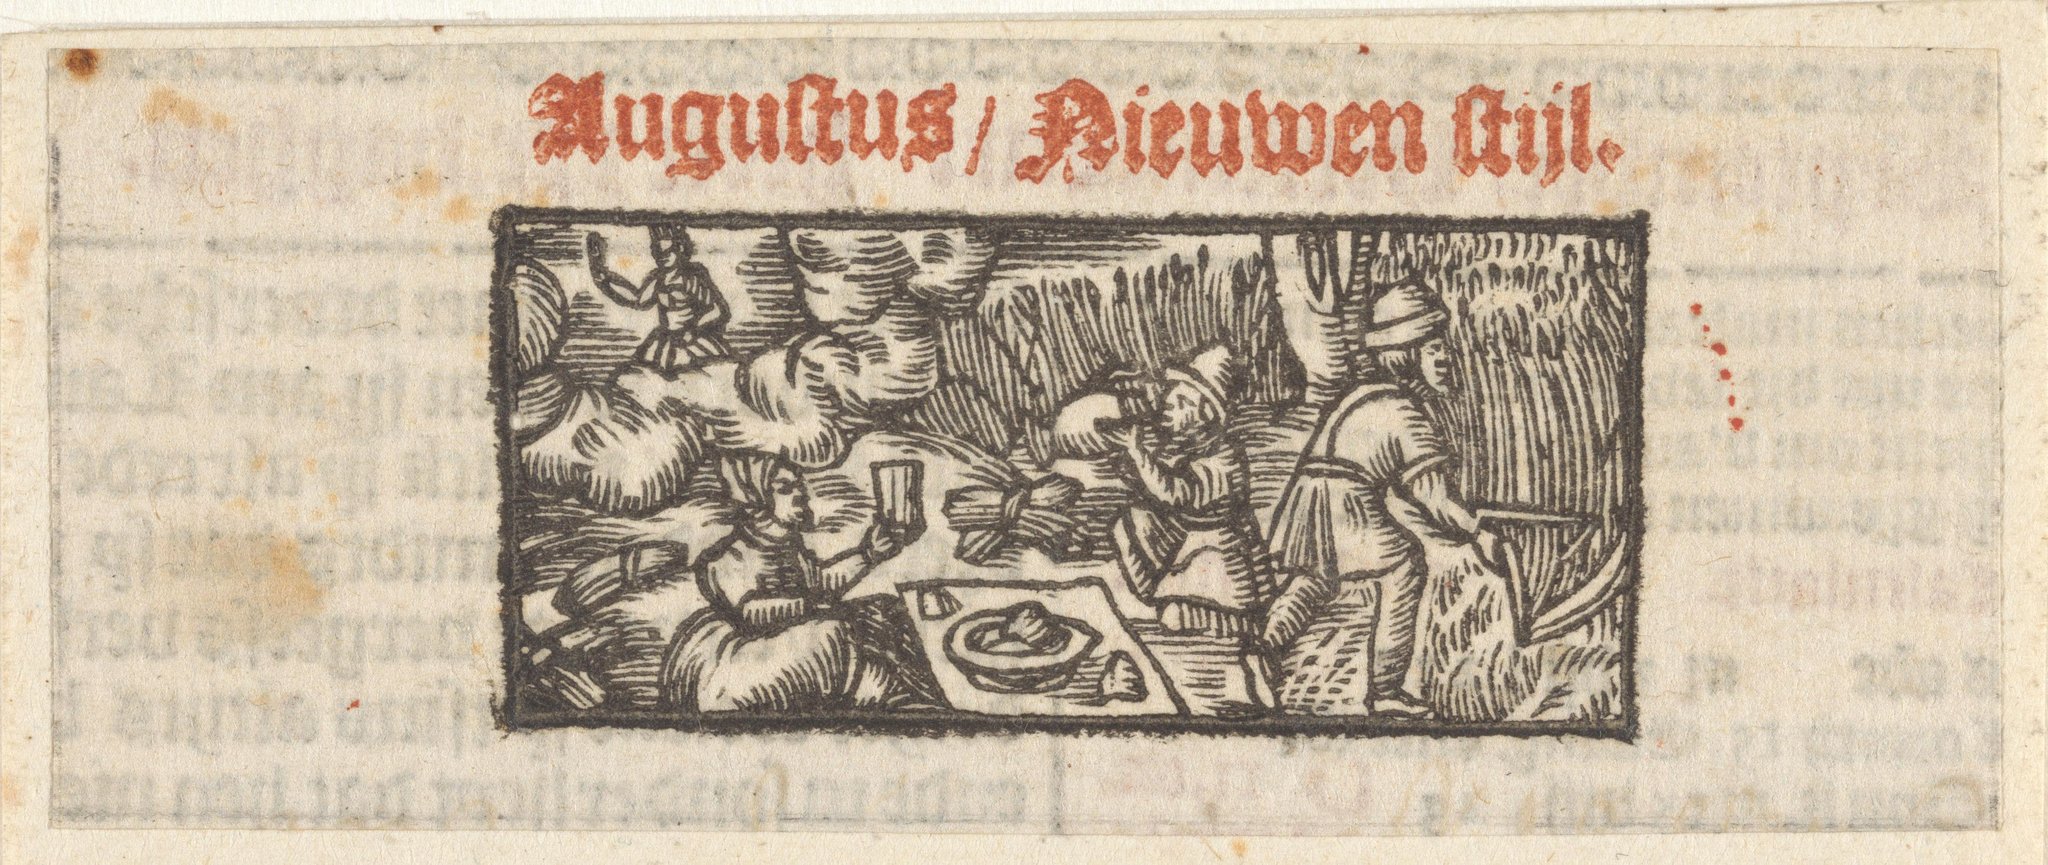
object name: book illustration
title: Augustus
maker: Anonymous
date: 1600-1699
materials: paper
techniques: letterpress printing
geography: netherlands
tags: august and its 'labours' (+ with virgo (august)), eating and drinking, reaping, picking, mowing ~ harvest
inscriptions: collector's mark: Lugt 240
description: Twee figuren etend en drinkend naast een maaier werkend op het land. Linksboven een maagd.